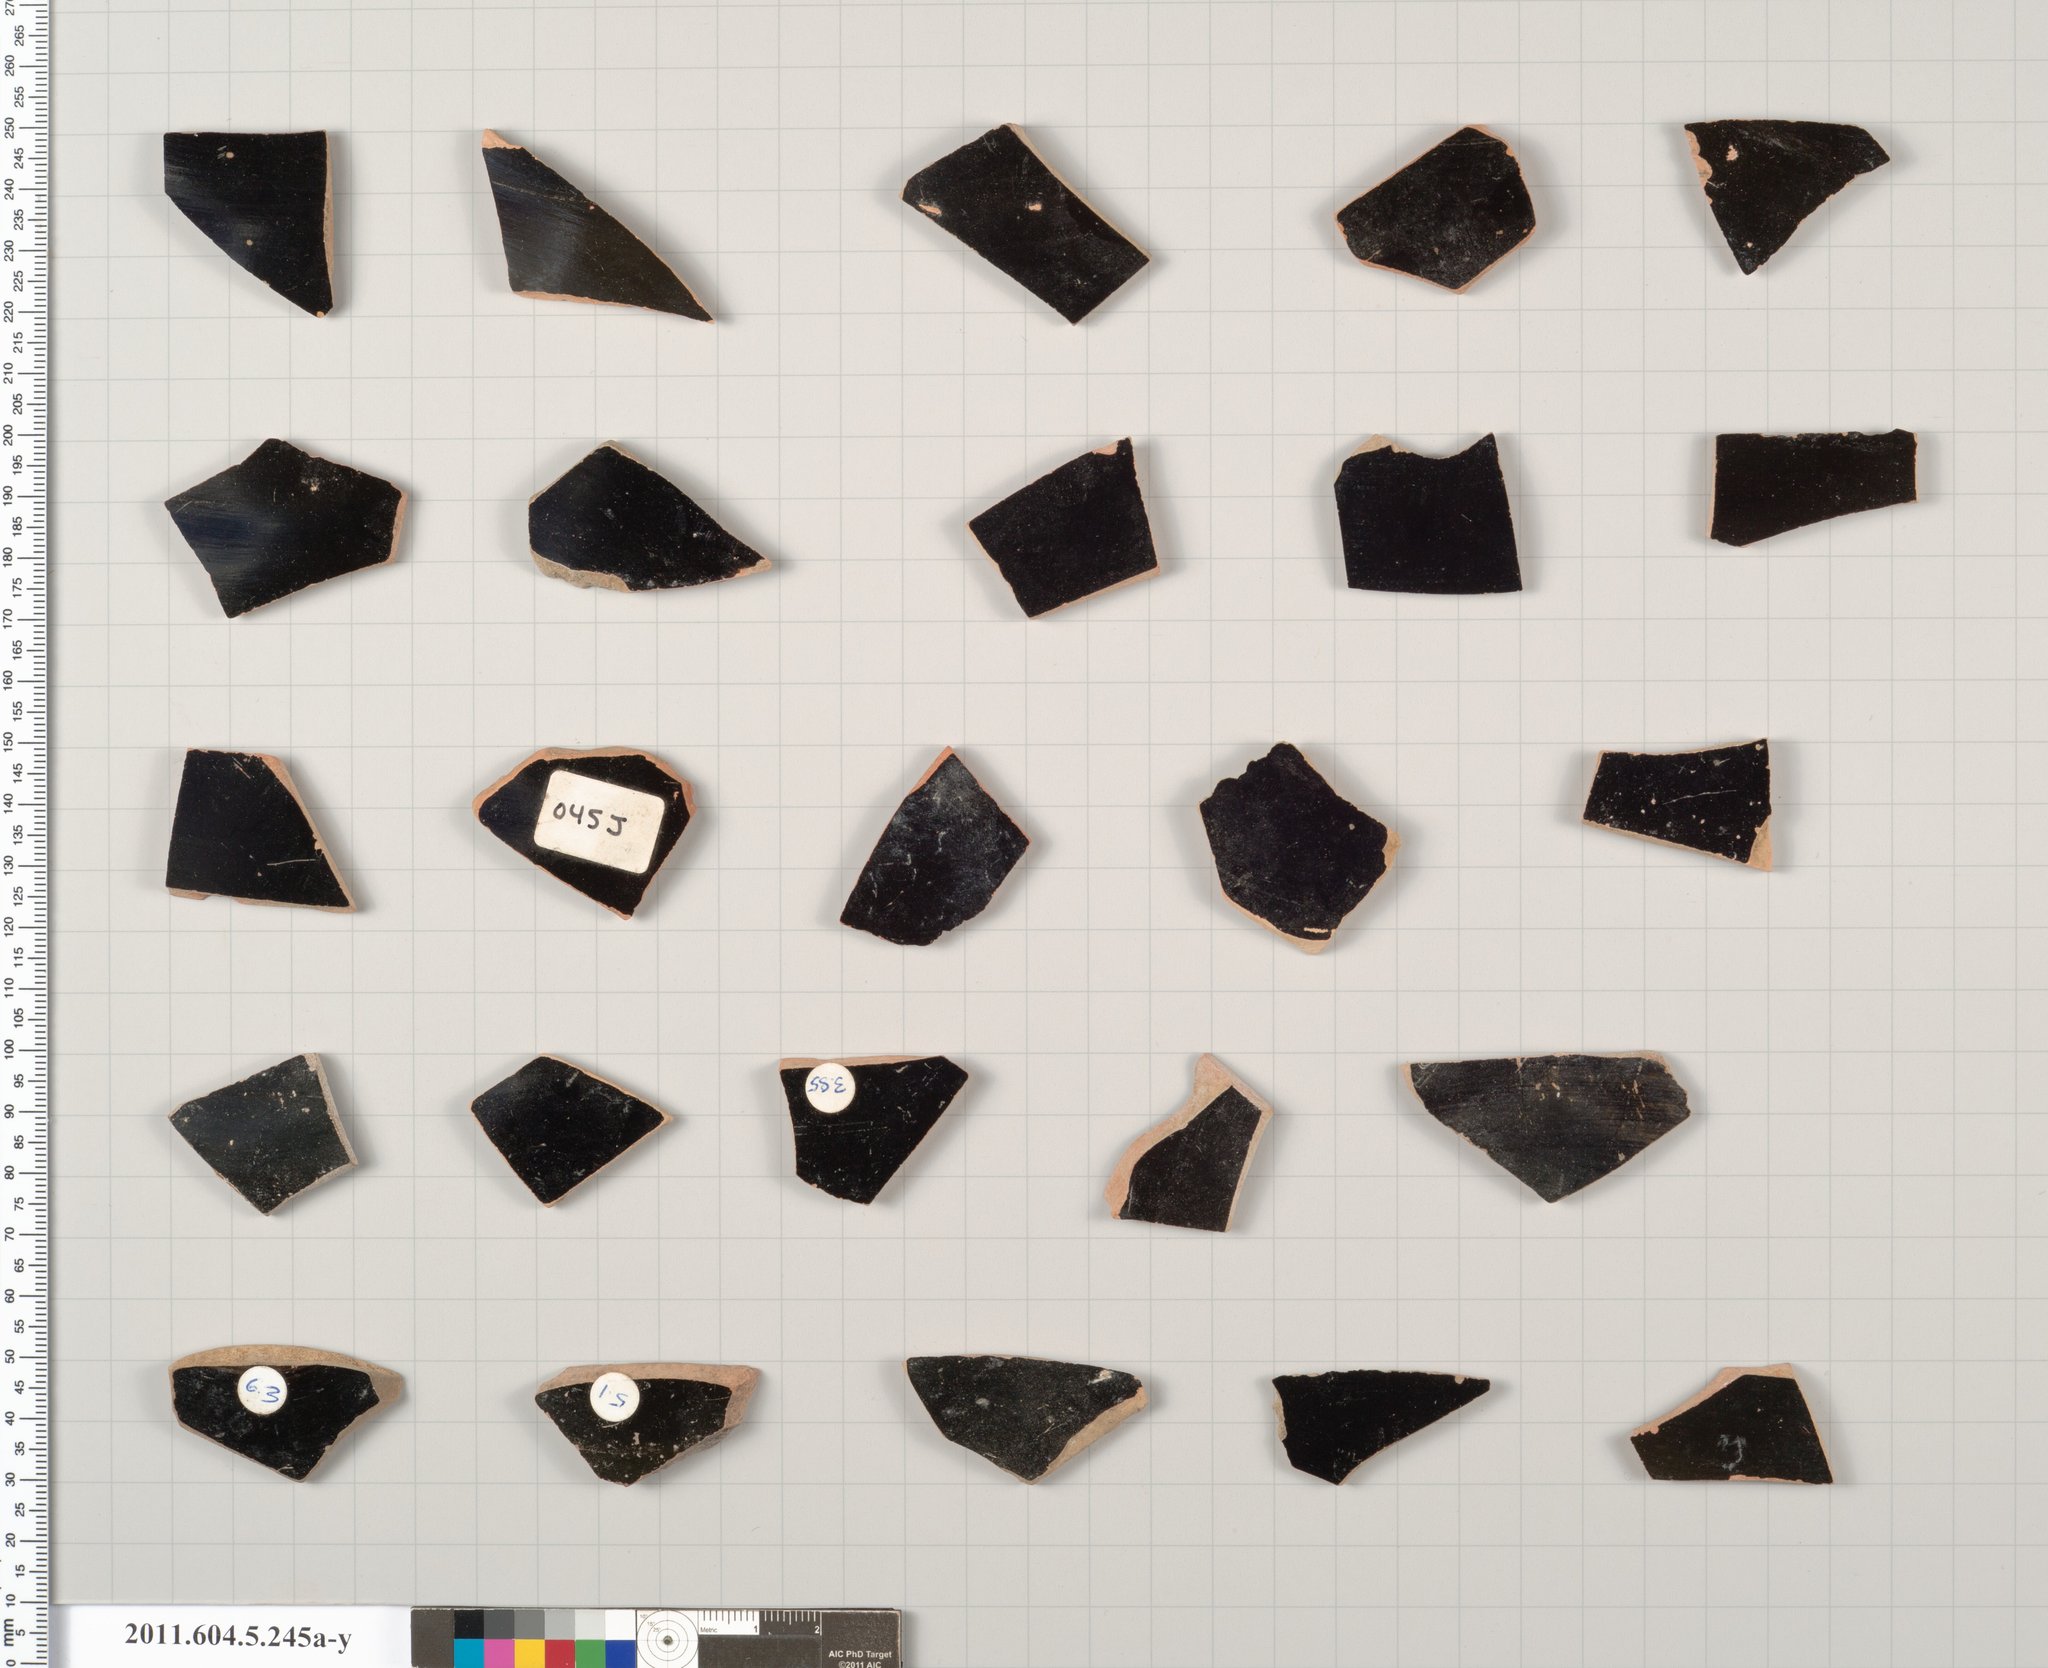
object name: kylix fragment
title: Terracotta fragments of kylikes (drinking cups)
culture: greek, attic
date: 600-401 BCE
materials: terracotta